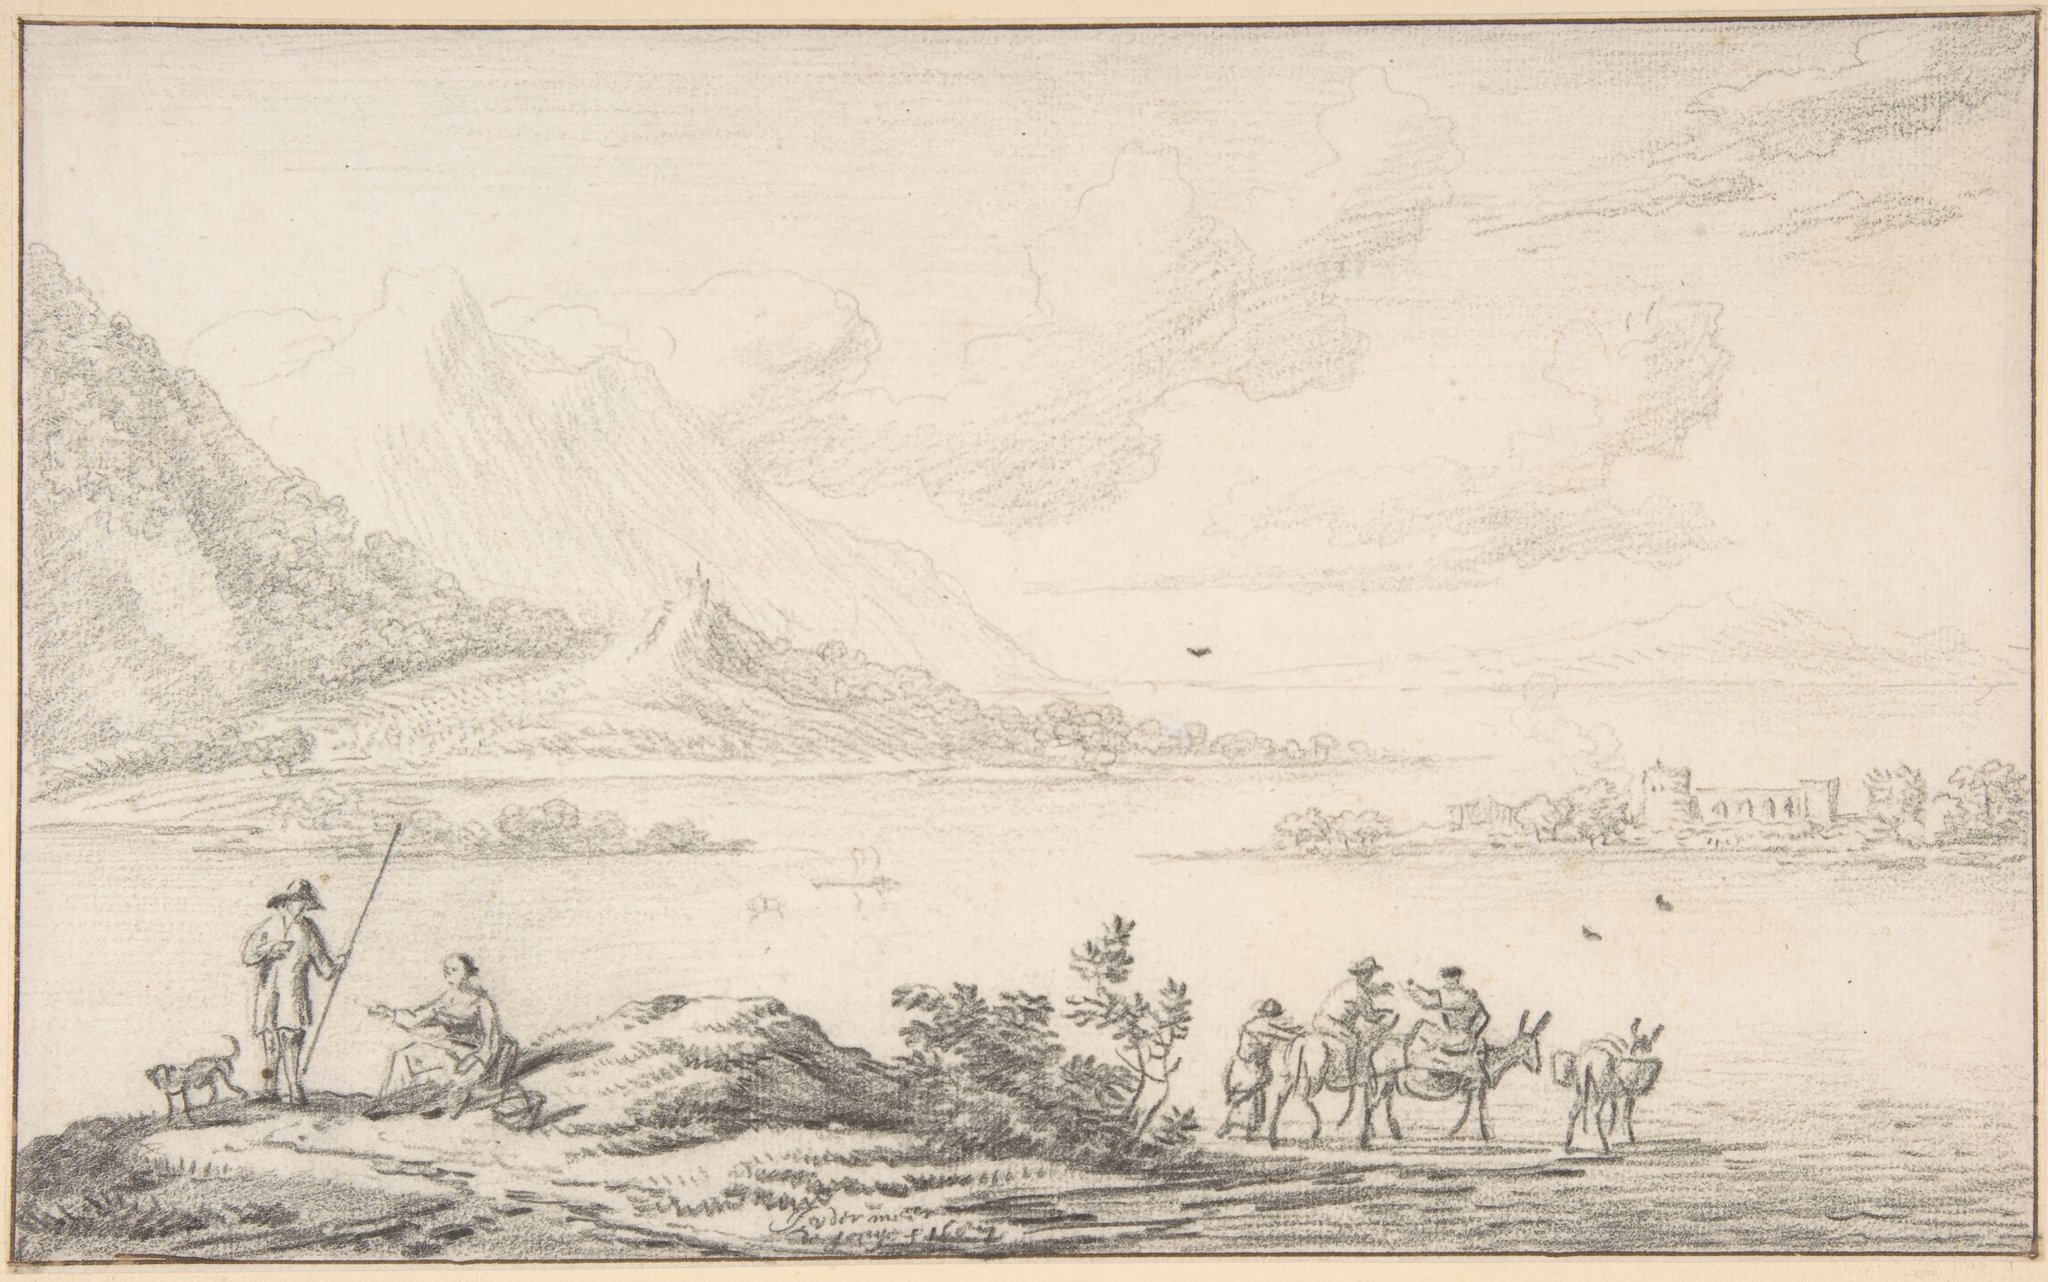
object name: drawing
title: Landscape with mountains and a lake, figures in the foreground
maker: jan van der meer the younger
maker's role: artist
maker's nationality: dutch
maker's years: 1656-1705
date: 1687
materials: chalk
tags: men,women,lakes,mountains,landscapes